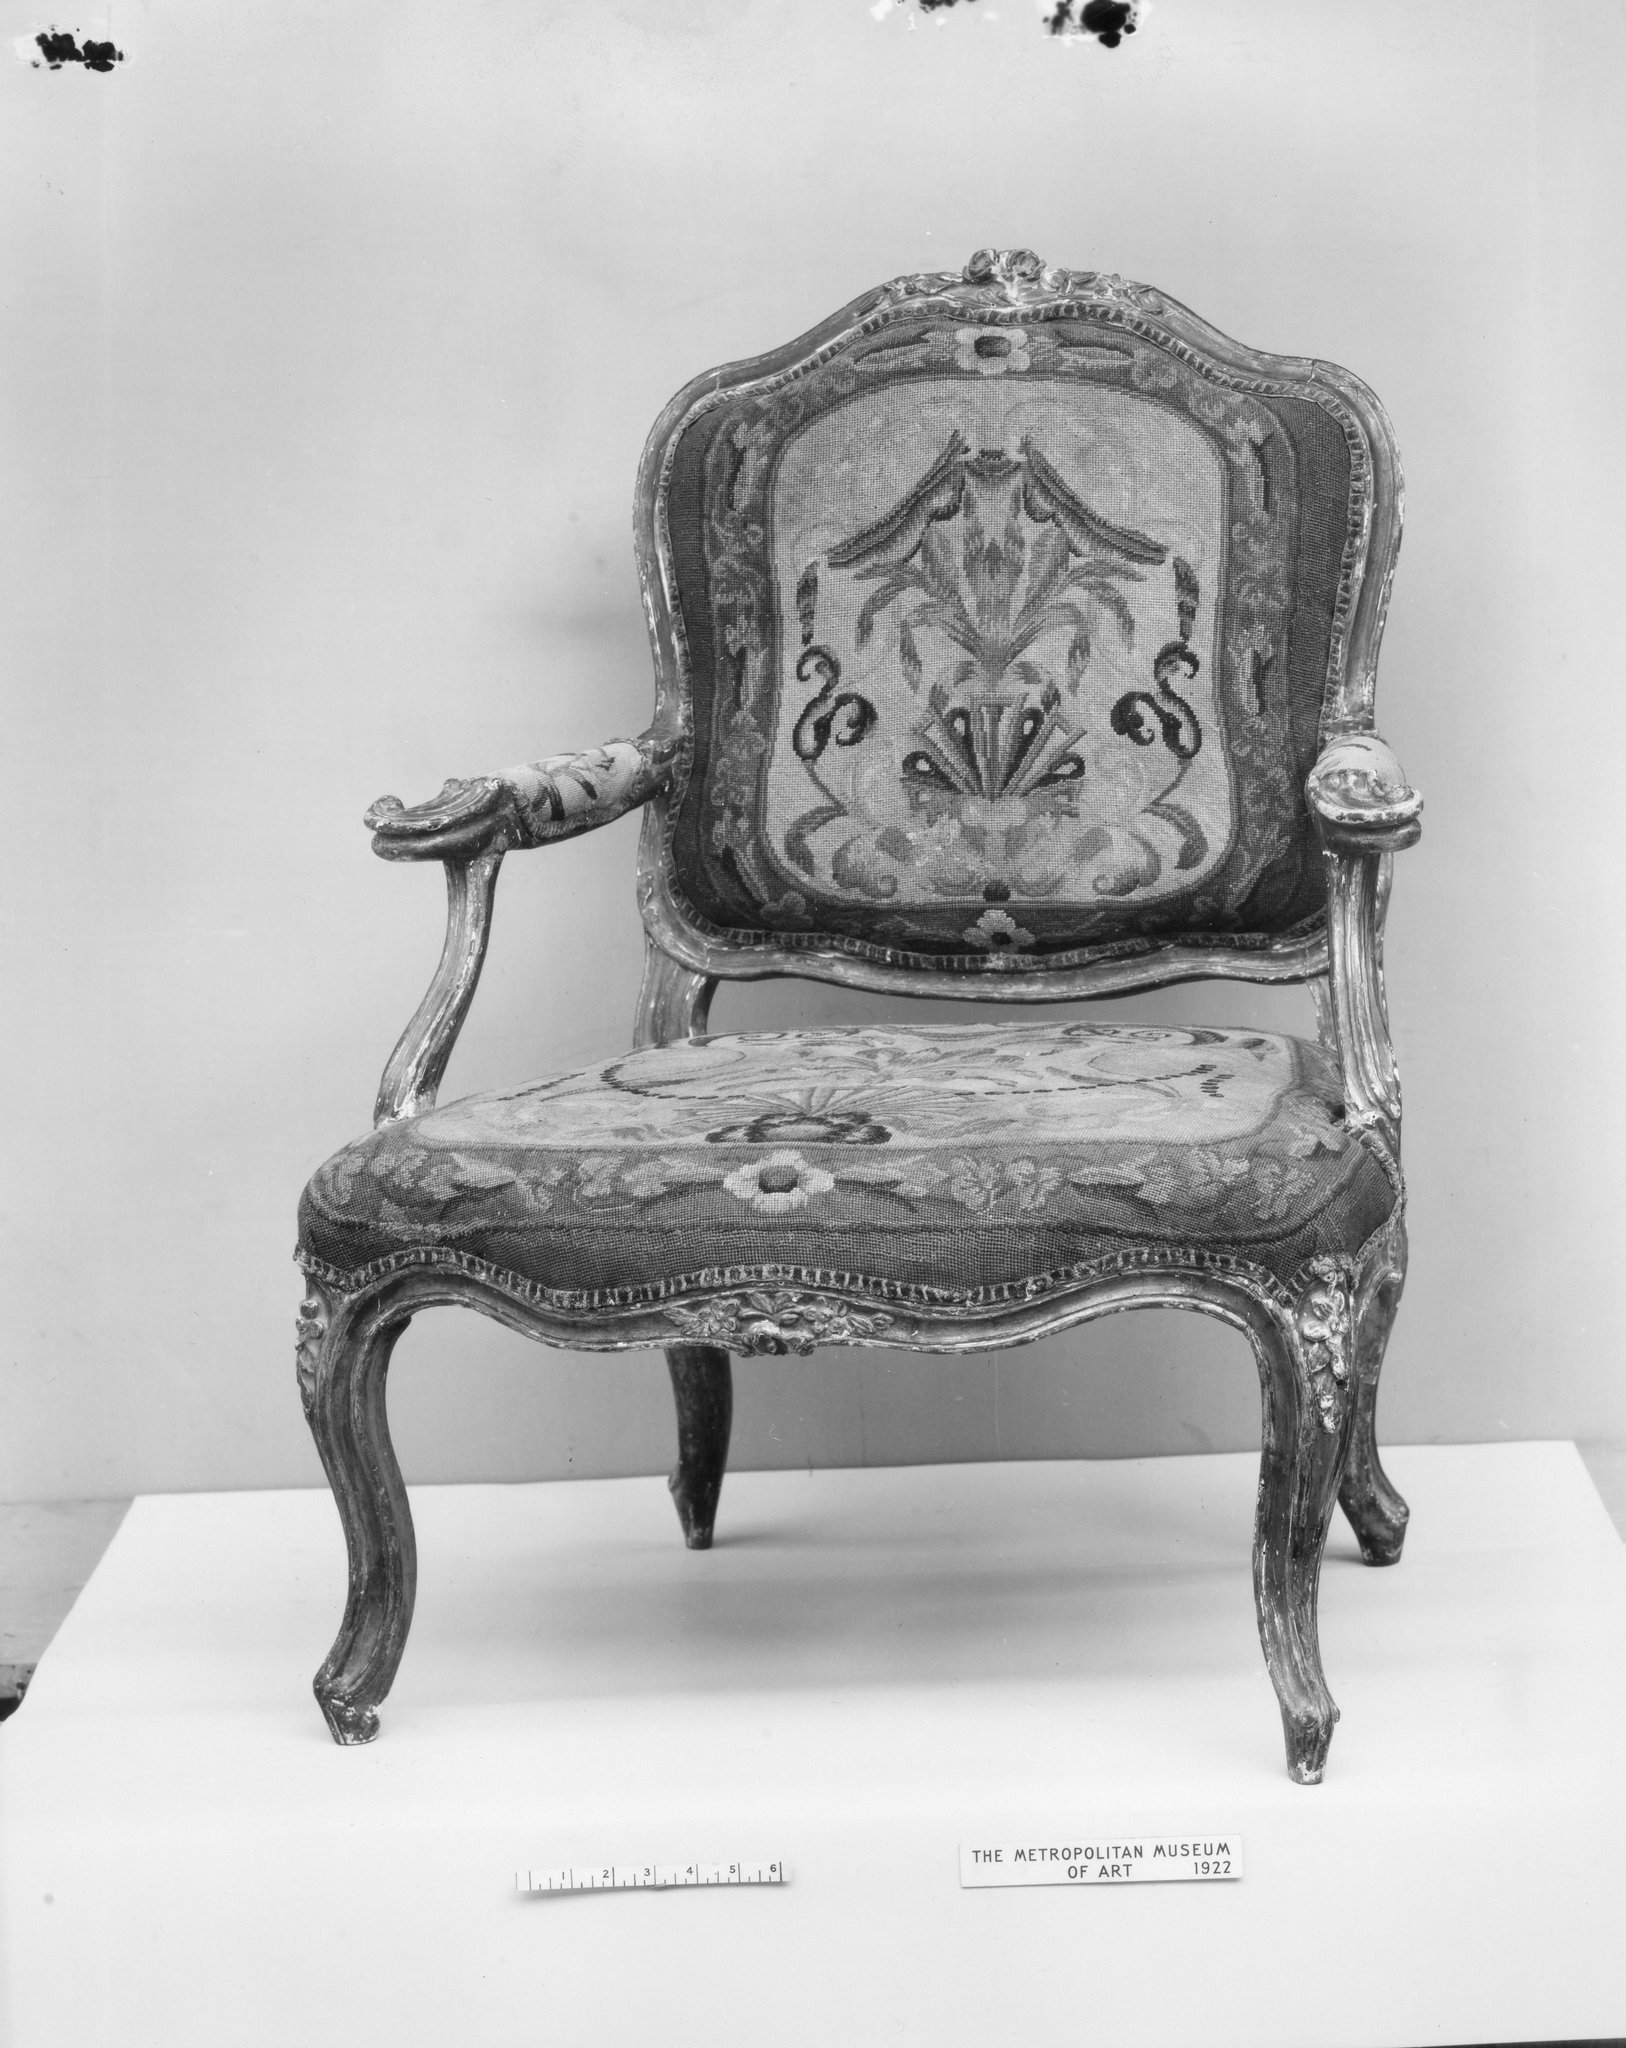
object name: armchair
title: Armchair (part of a set)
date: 1734-1766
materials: wood, wool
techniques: embroidery, painting, silvered